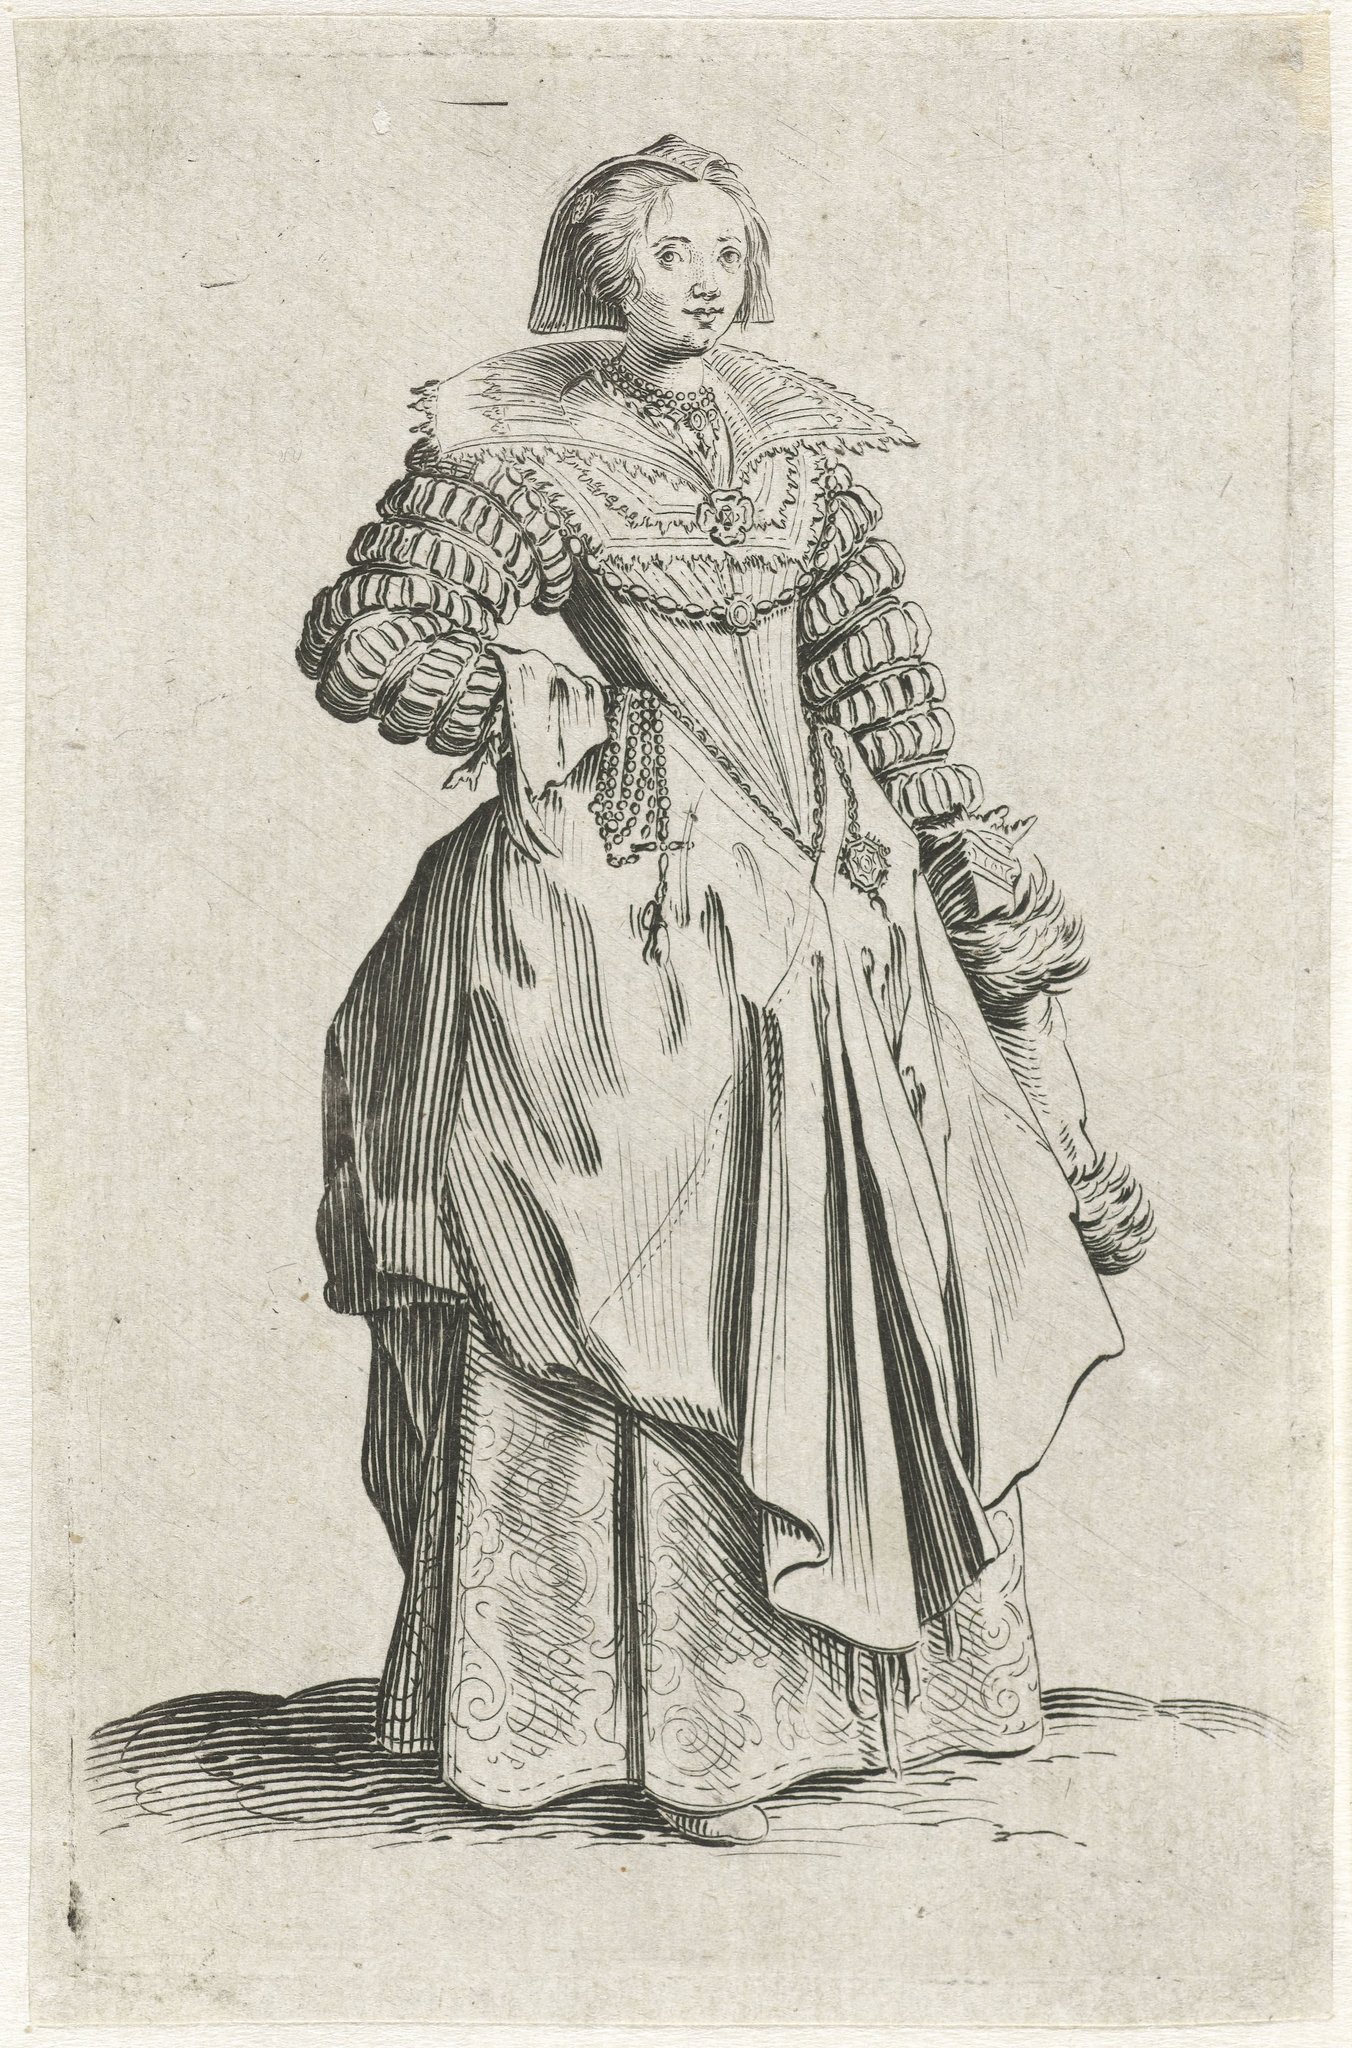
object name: costume print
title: Dame met mutsje, rozenkrans en mof, van voren gezien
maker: abraham bosse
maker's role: draughtsman, print maker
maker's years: 1602-1676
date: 1620-1650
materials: paper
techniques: engraving, etching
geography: paris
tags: muff, aids for prayer, e.g. rosary, skirt (underskirt) (+ women's clothes), head-gear: cap (+ women's clothes), neck-gear: collar (+ women's clothes), clothes, costume (+ women's clothes), skirt (+ women's clothes), sleeves: cuffs (+ women's clothes), dress, gown (+ women's clothes), sleeves (+ women's clothes), clothing for the upper part of the body (with name) (+ women's clothes), nobility and patriciate; chivalry, knighthood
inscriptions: collector's mark: Lugt 240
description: Staande dame, min of meer van voren gezien, gekleed in een japon met brede kanten kraag, een plat mutsje op het hoofd, een rozenkrans in de ene hand en een mof in de andere. Deze prent is onderdeel van een serie van 12 (?) prenten met edellieden in kostuums die gedragen werden in Lotharingen in het eerste kwart van de 17e eeuw; de helft van de serie betreft herenkostuums, de andere helft toont dameskostuums.